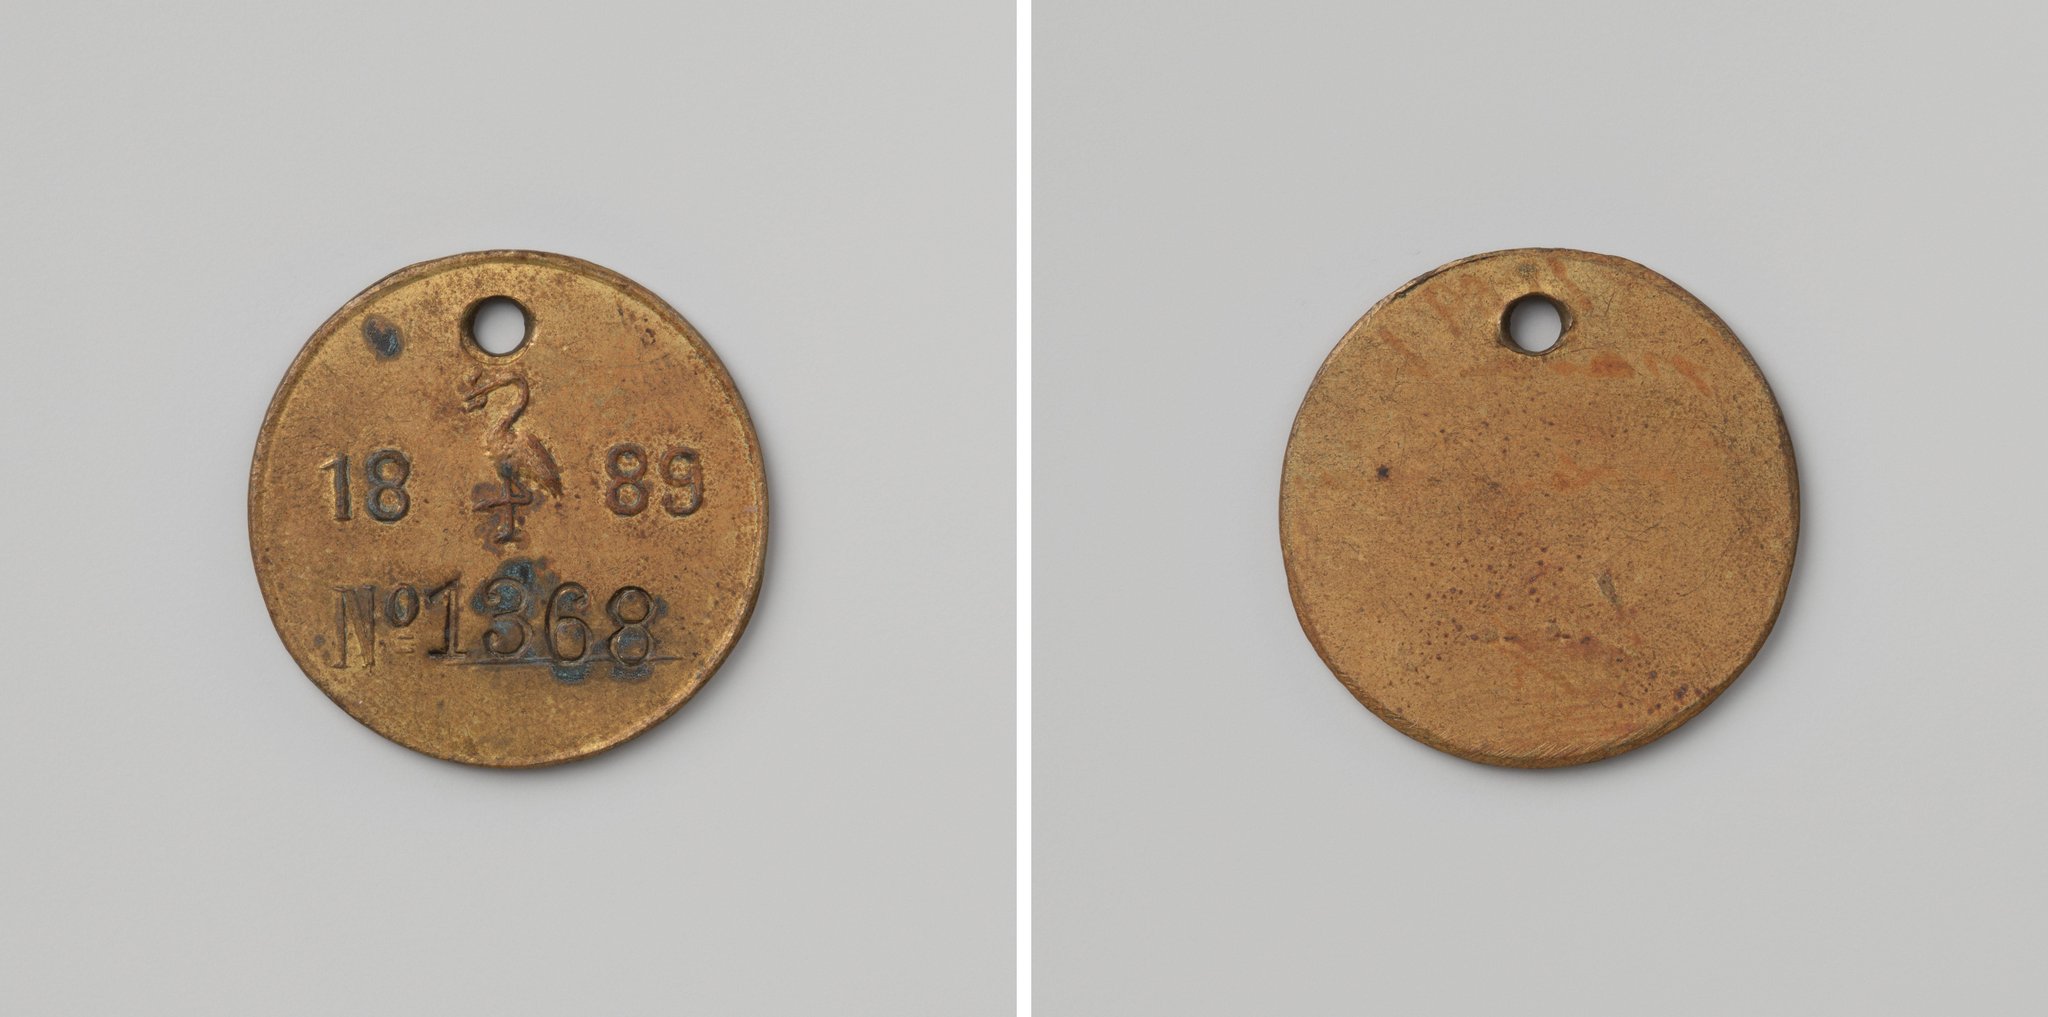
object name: hondenbelastingloodje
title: Stad 's-Gravenhage, loodje met no. 1368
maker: Anonymous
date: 1889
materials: brass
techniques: striking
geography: the hague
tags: the hague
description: eenzijdig loodje met gat erin. Voorzijde: staande ooievaar tussen jaartal boven cijfer no. 1368. Keerzijde: blanco